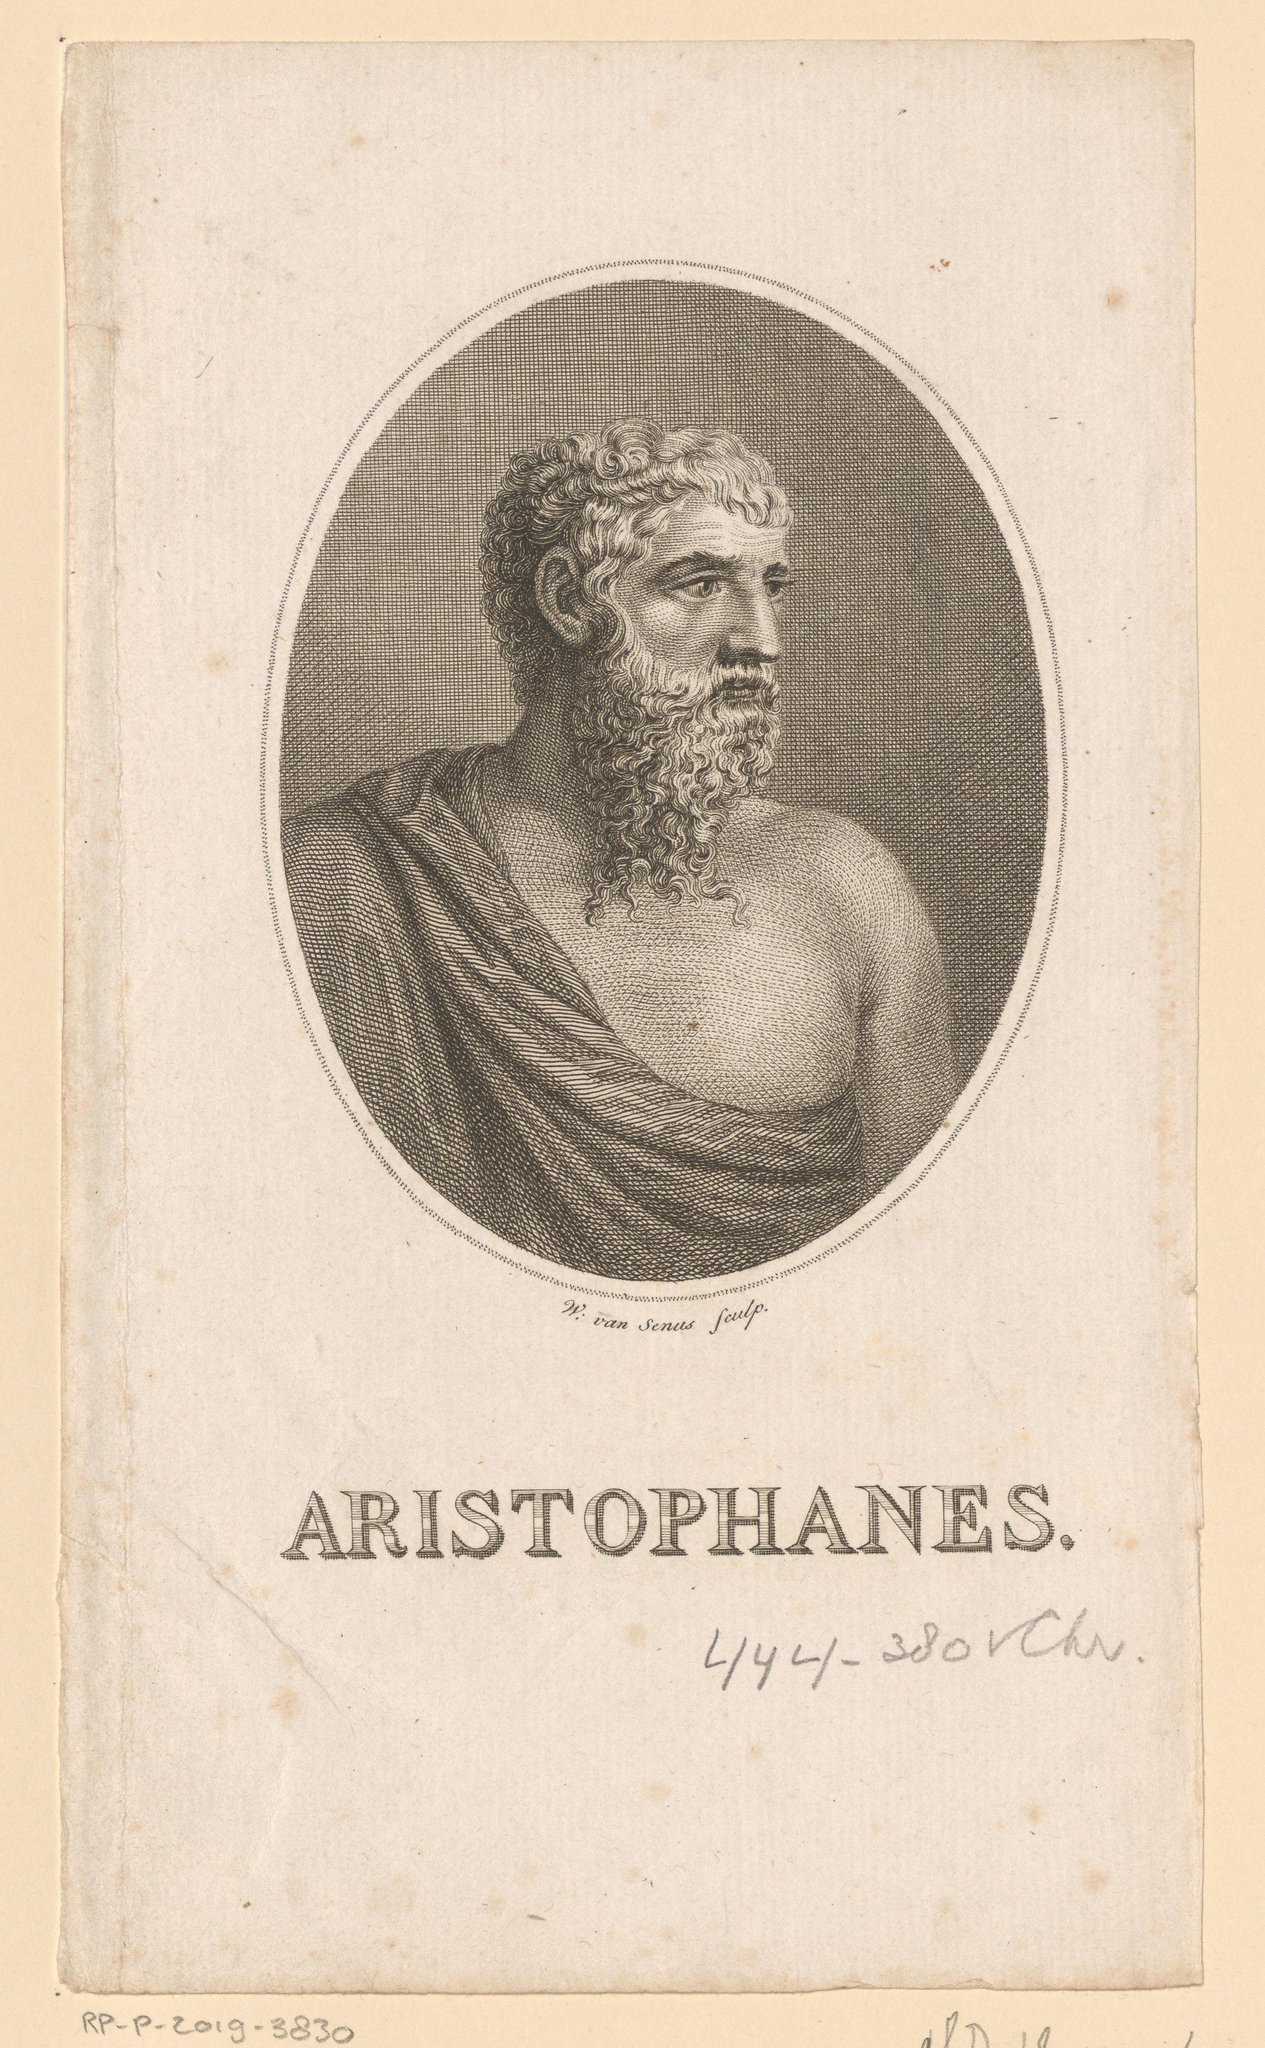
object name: print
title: Portret van Aristophanes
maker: willem van senus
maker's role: painter, print maker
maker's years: 1773-1851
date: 1787-1851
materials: paper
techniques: engraving, etching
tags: historical persons